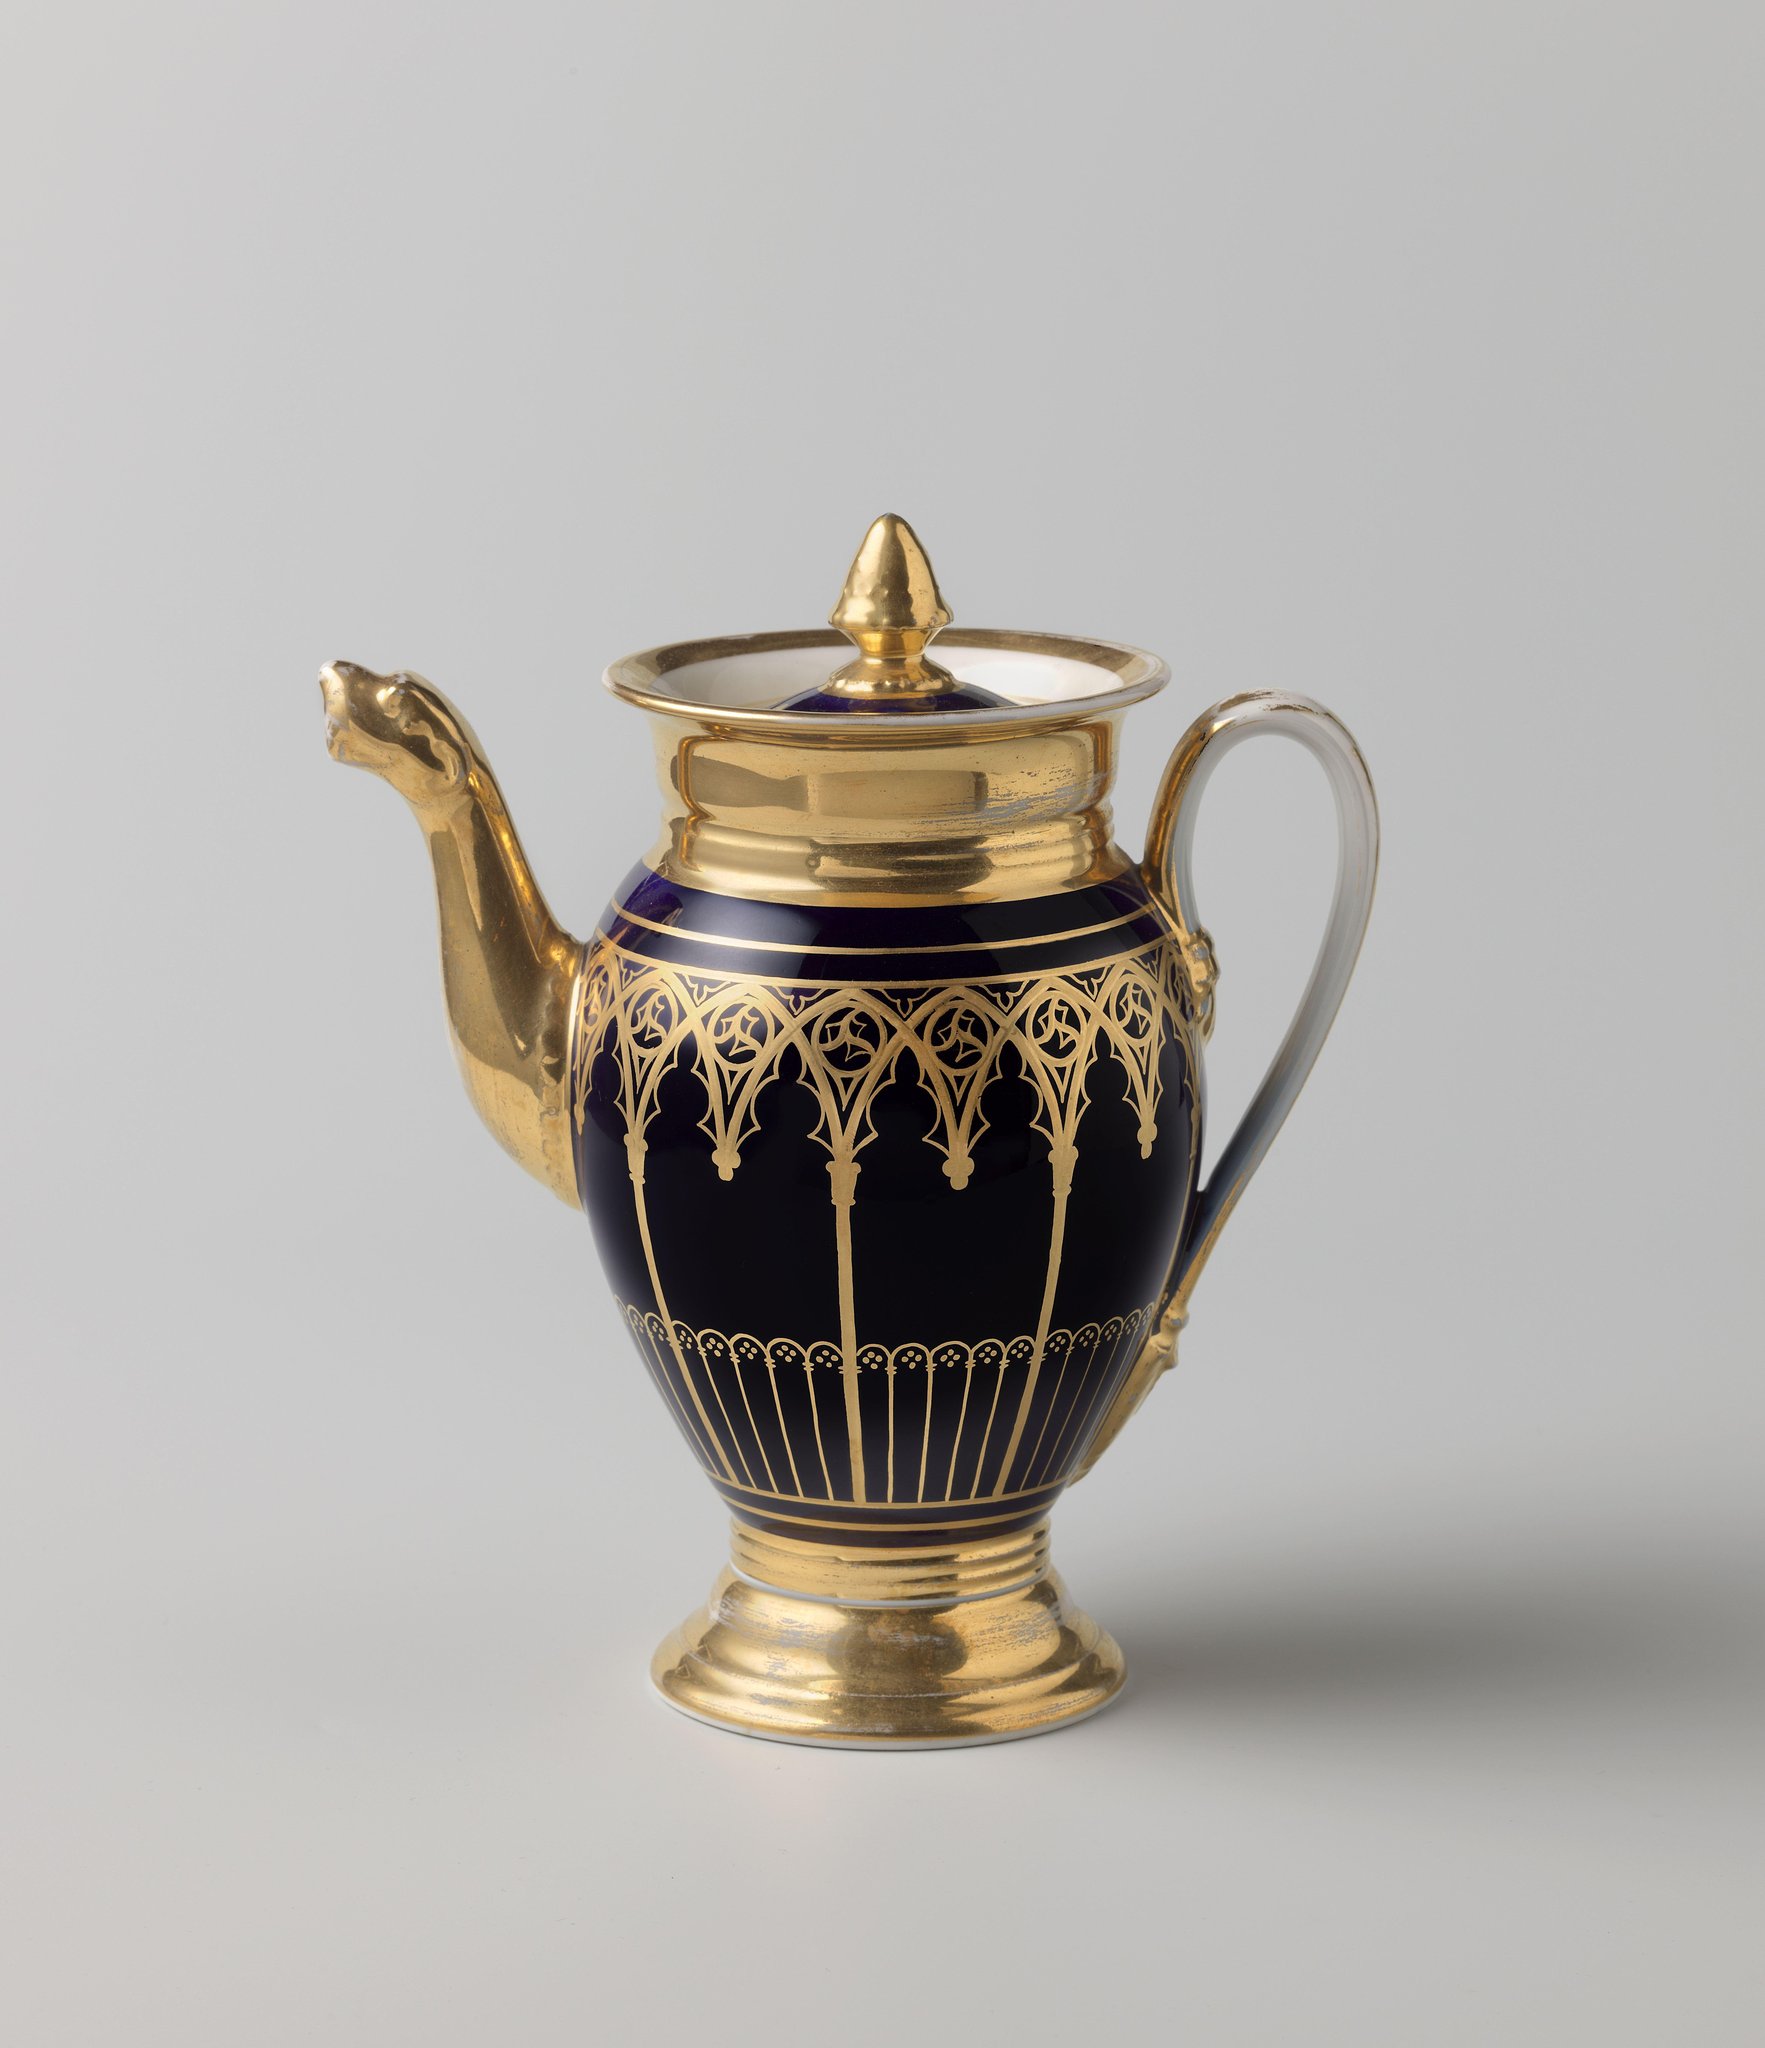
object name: service set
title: Cover of a teapot with a gothic arcade decoration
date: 1800-1899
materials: cobalt, glaze, gold, paint, porcelain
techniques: firing, forming, gilding, turning, vitrification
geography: saint-yrieix-la-perche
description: Theepot van porselein, deel van een servies, beschilderd in goud op een koningsblauw fond met een arcademotief met gotische traceringen. Buiten dit decor is het gehele oppervlak verguld. Merken: zie algemeen record.